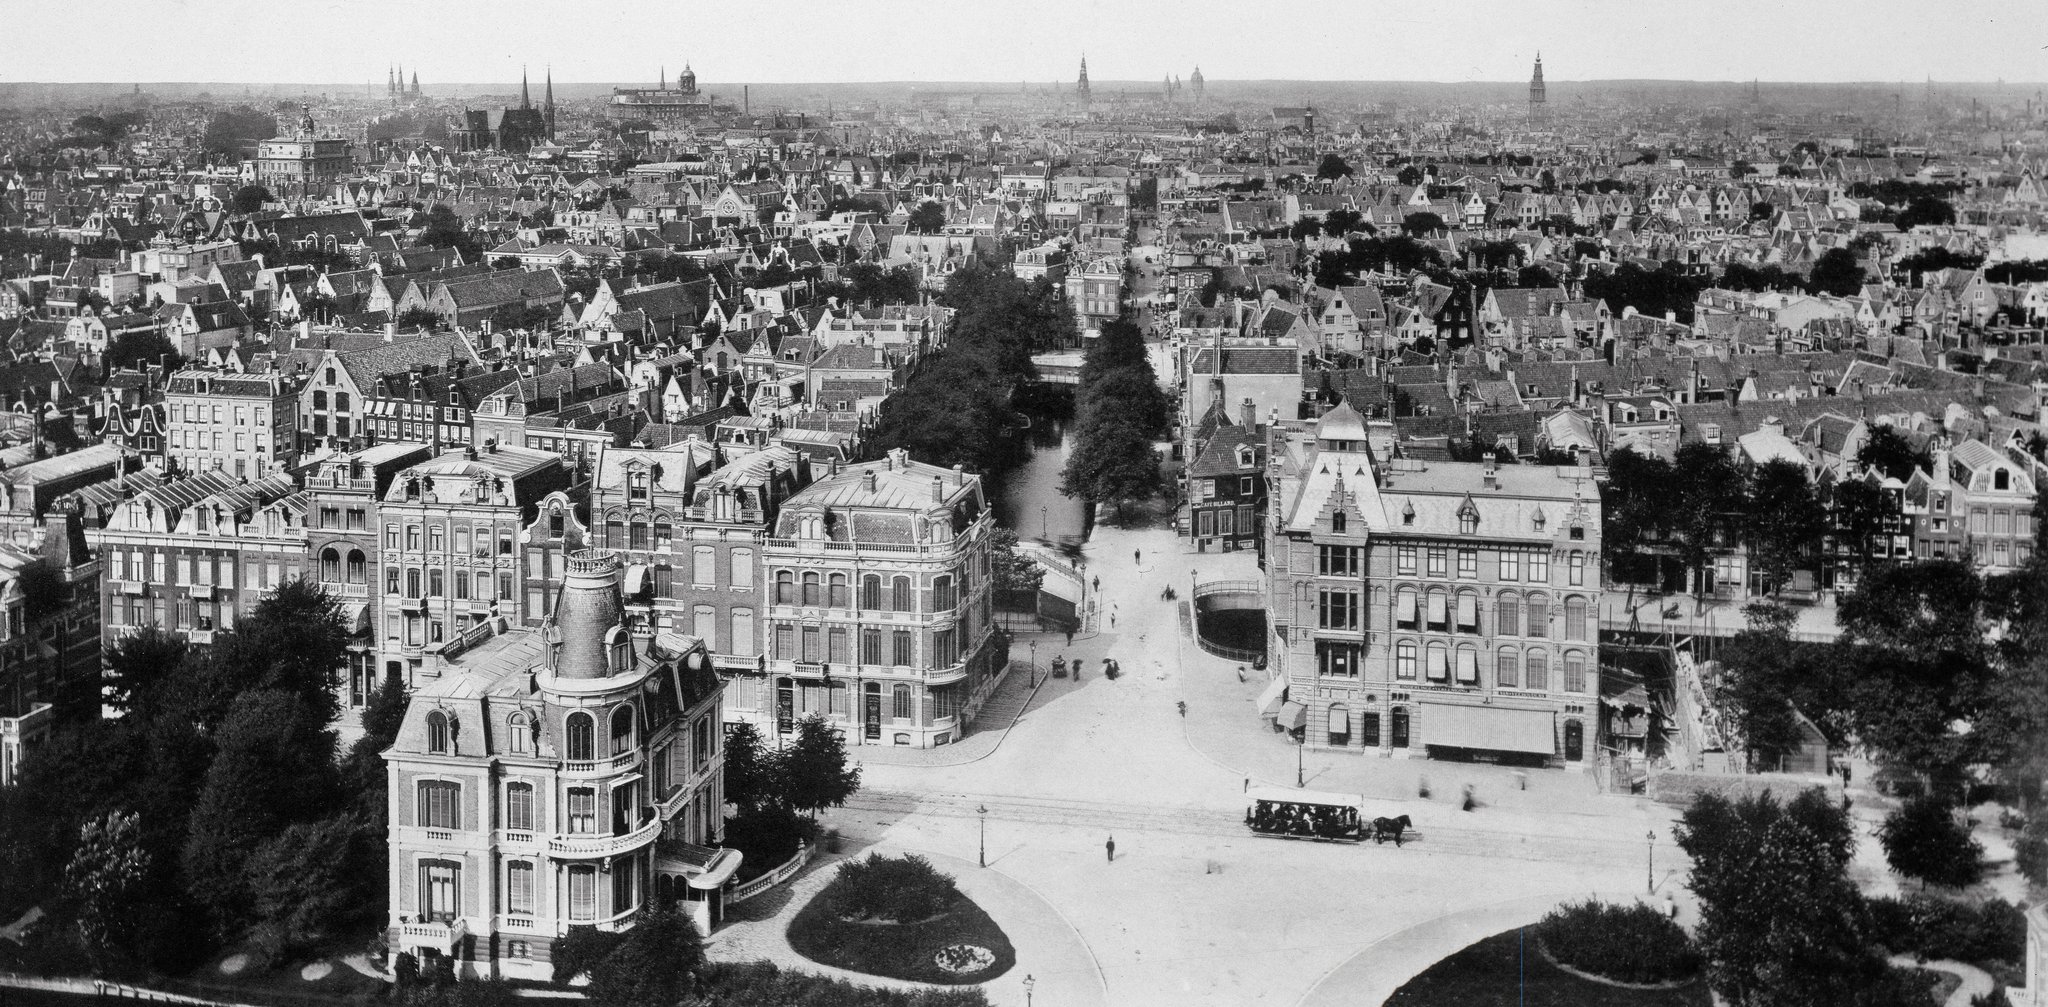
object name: photomechanical print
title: Kerk "de Posthoorn", Kerk "de Krijtberg", Paleis, Oudekerk, Spiegelgracht, St. Nicolaas-kerk, Zuiderkerk, Weteringschans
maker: gerrit hendricus heinen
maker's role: painter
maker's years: 1851-1930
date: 1889-1894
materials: paper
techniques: photograph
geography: amsterdam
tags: urban housing, city-view in general; 'veduta', royal palace of amsterdam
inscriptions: check stamp: ‘G.H. Heinen Amsterdam/ Schilder & Fotograaf’